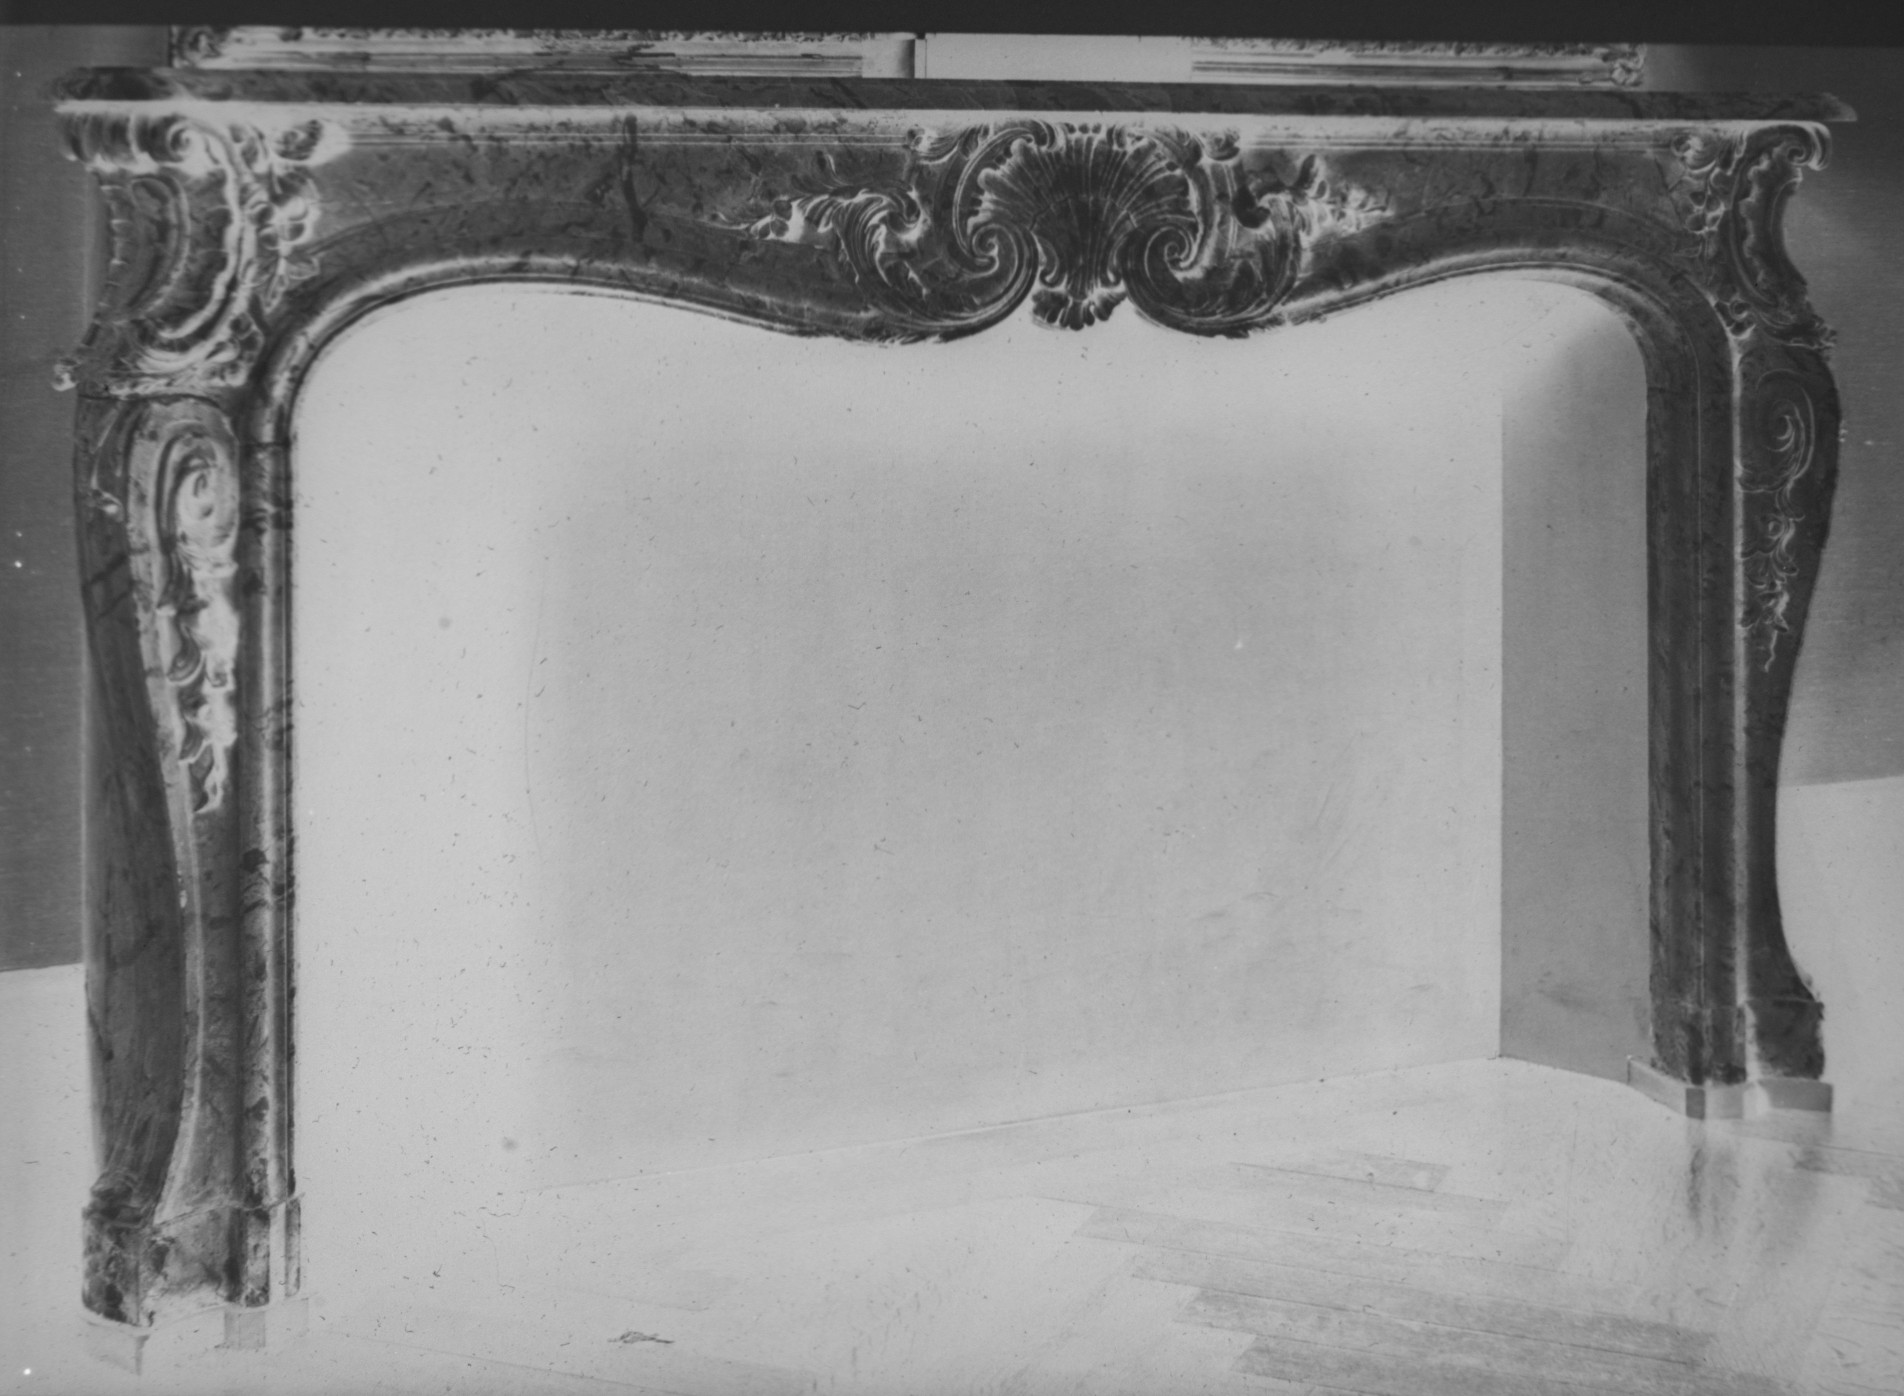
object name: mantel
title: Chimneypiece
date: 1740-1750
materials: marble